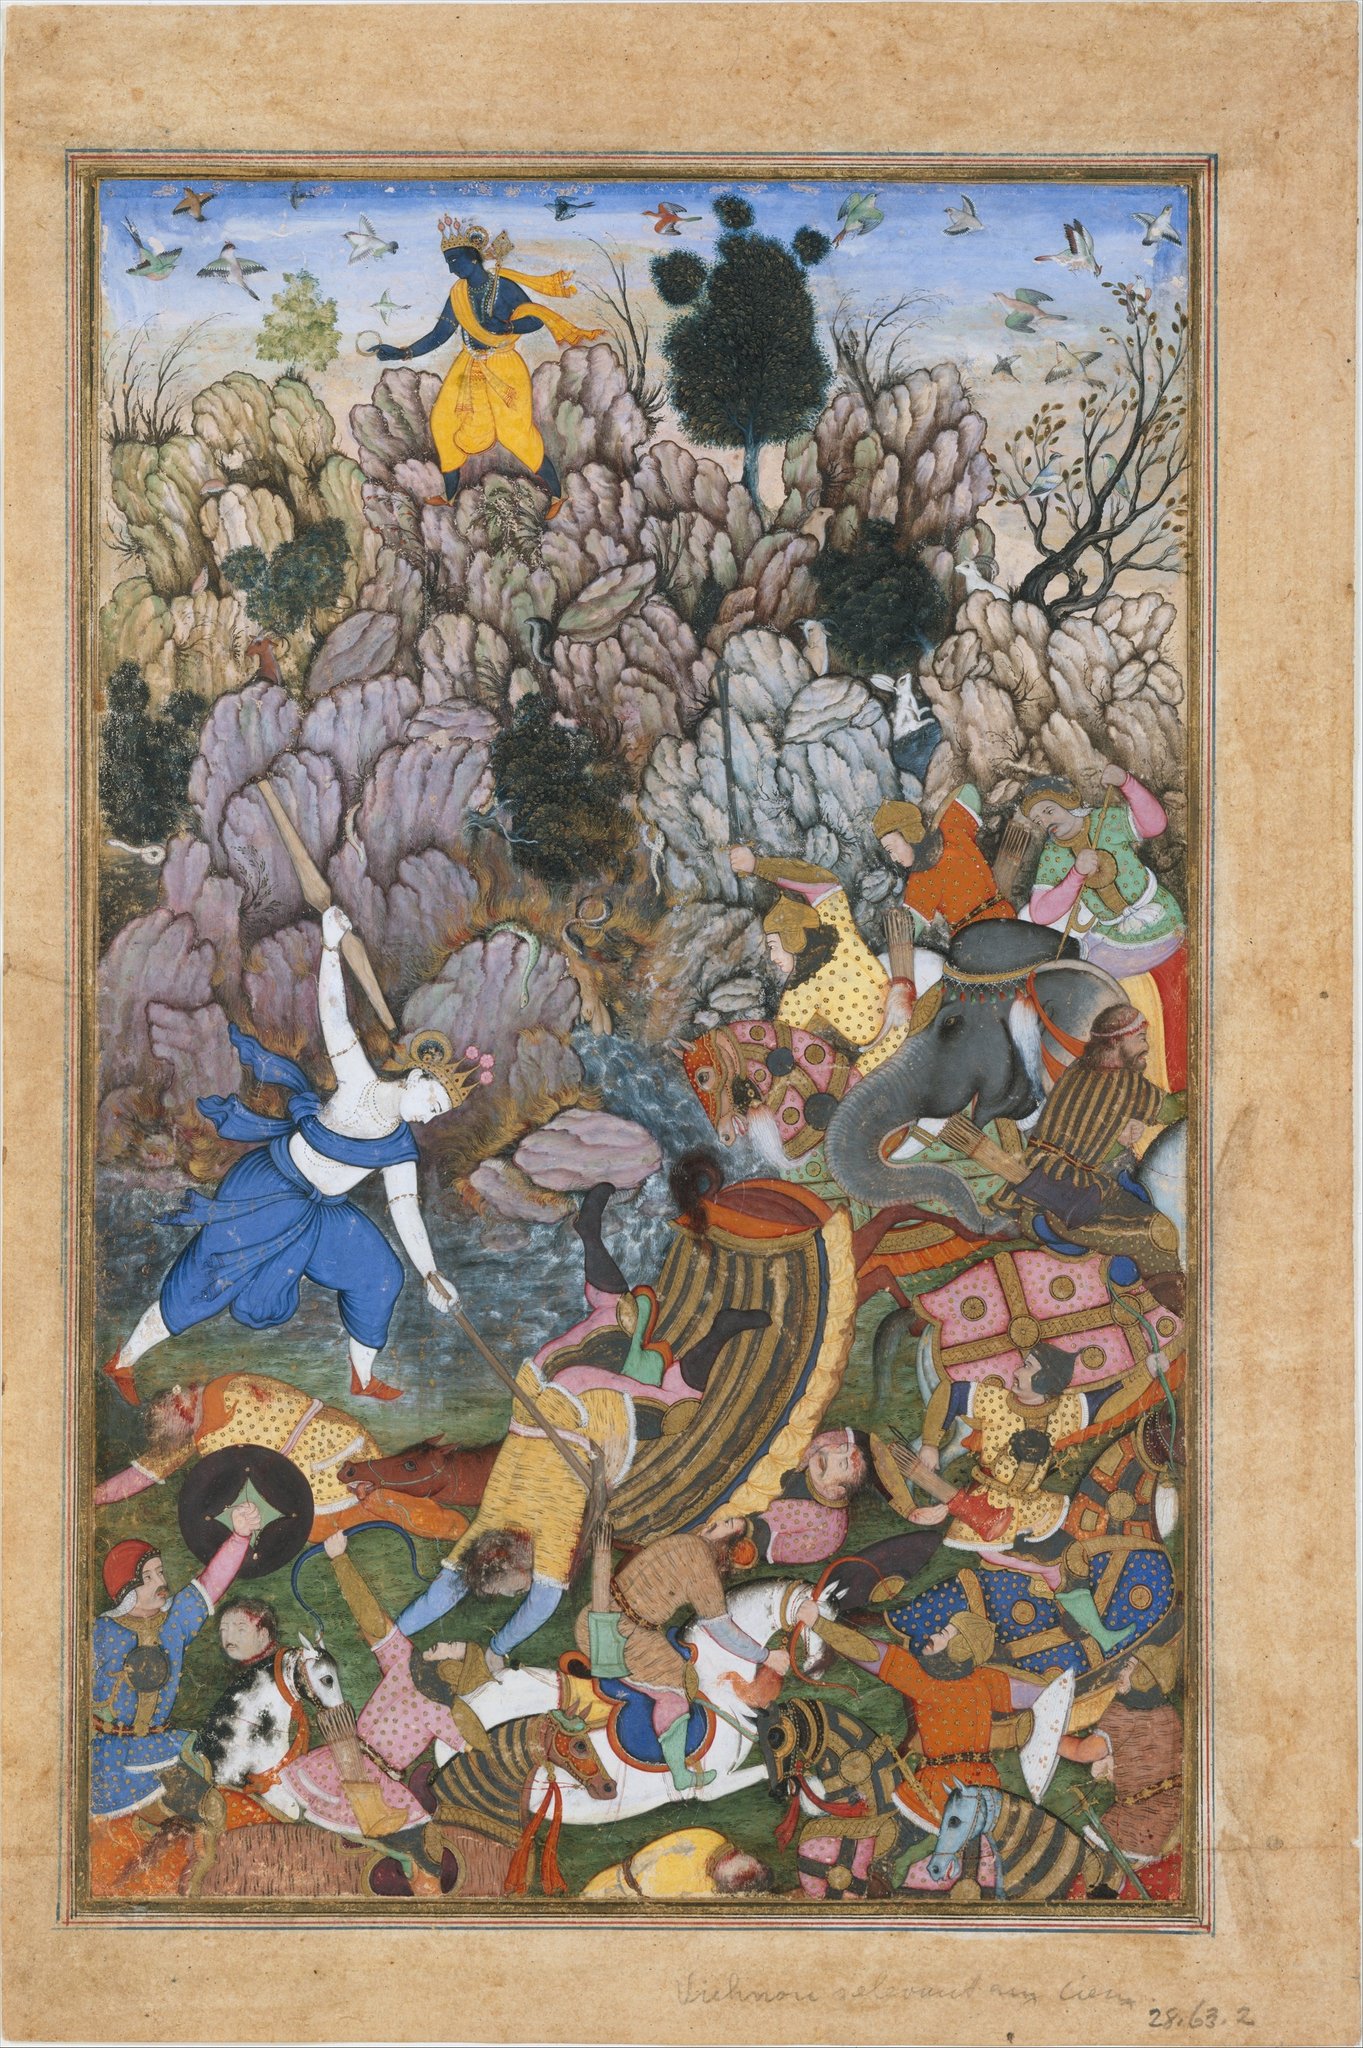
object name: folio from an illustrated manuscript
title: "Balarama and Krishna Fighting the Enemy", Folio from a Harivamsa (The Legend of Hari (Krishna))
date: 1590-1595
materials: gold, ink, paper, watercolor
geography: pakistan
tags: battles,army,soldiers,krishna,vishnu